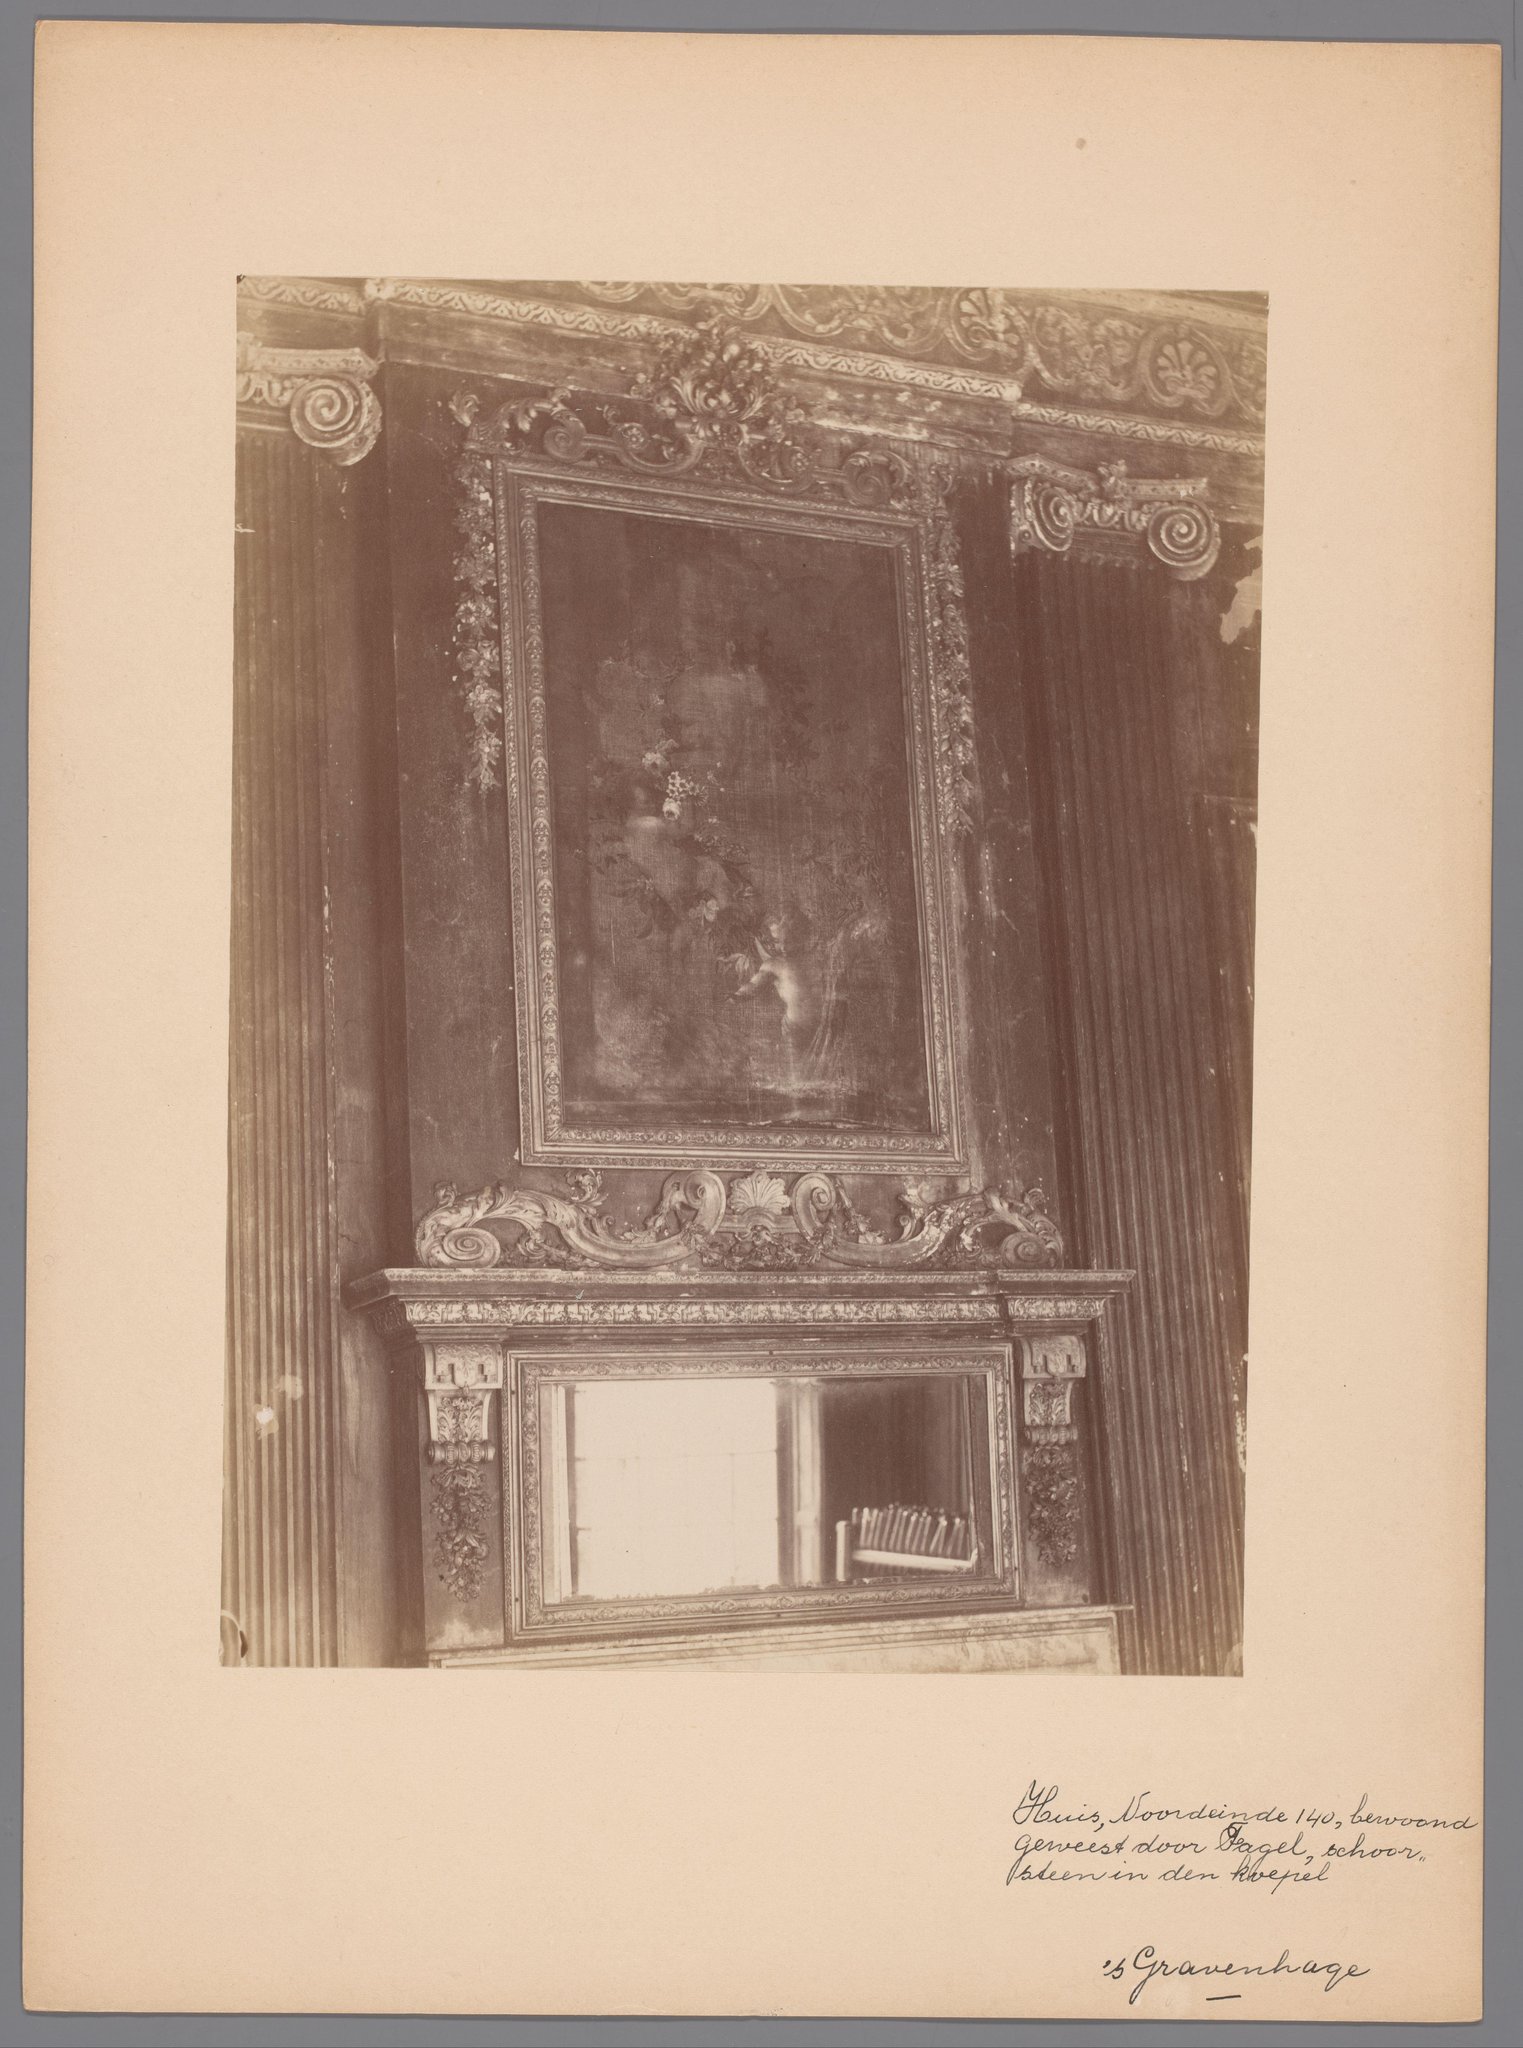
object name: photograph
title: Kamer met schoorsteen van Noordeinde 140 te Den Haag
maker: anoniem (monumentenzorg)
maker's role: fotograaf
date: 1900-1910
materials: cardboard, photographic support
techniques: albumen print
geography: noordeinde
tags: interior of the house, chimney-piece, mantelpiece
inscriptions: annotation: ‘Huis Noordeinde Haag/ Bewoond door Mevr Hoogen[...]/ schoorsteen in den koepel’, annotation: ‘Huis, Noordeinde 140, bewoond geweest door Fagel, schoorsteen in den koepel/ 's Gravenhage’, collector's mark: ‘R:MUS.’ Lugt 2228